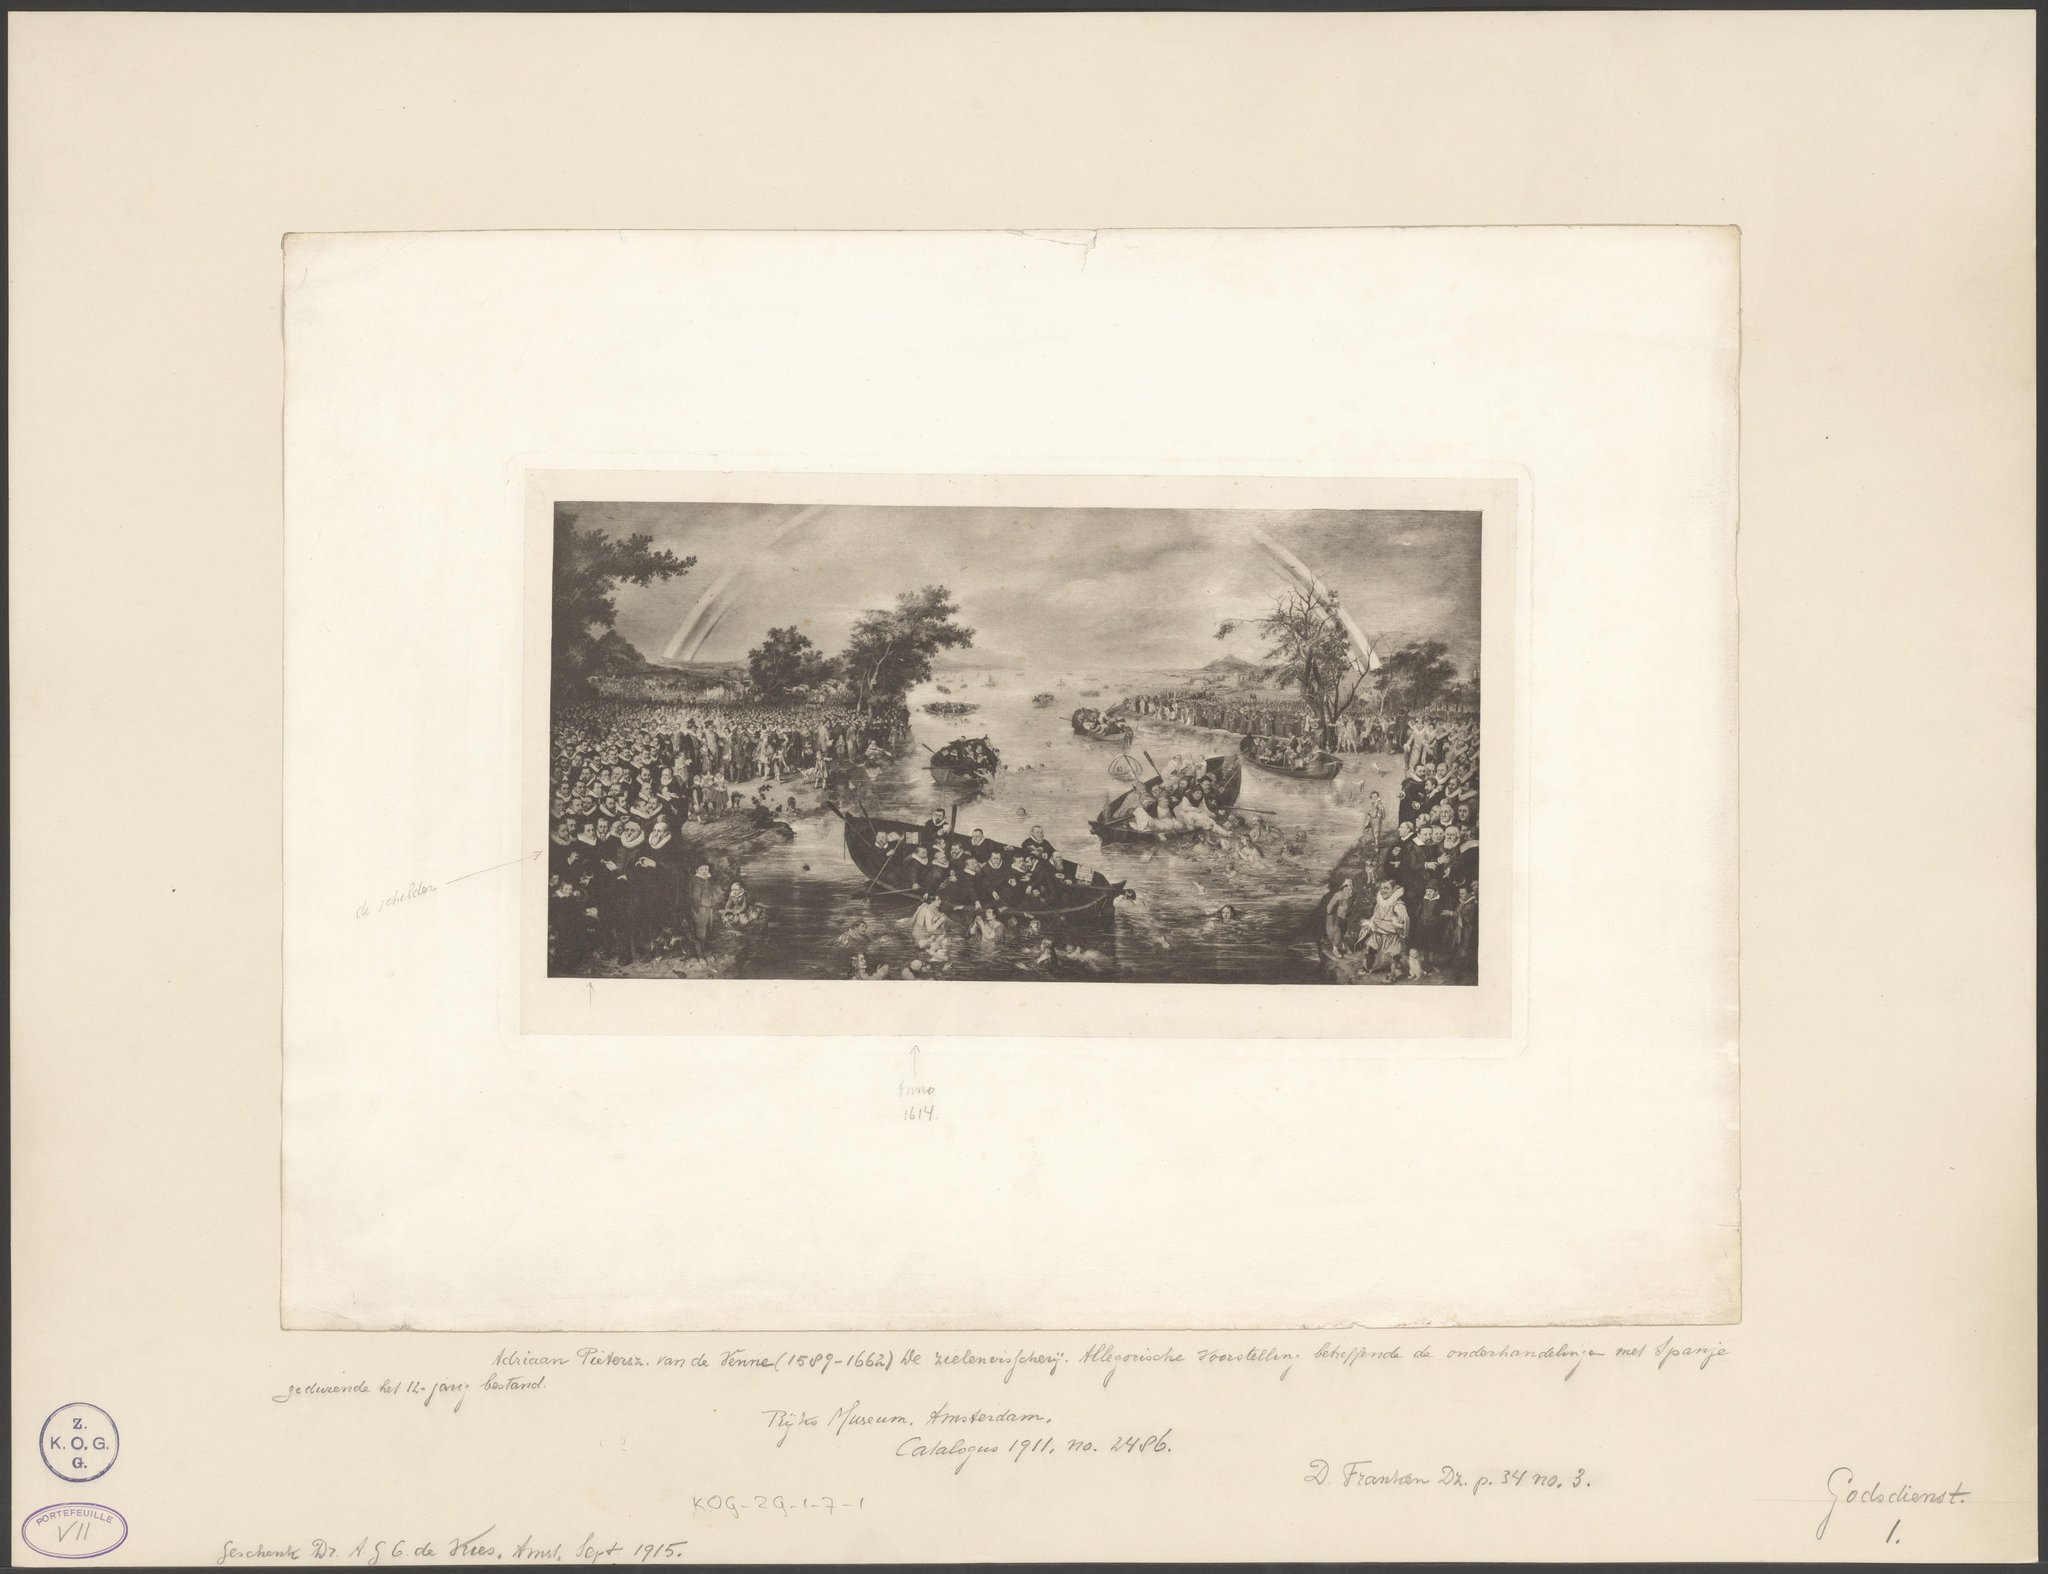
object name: reproduction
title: Reproductie van De zielenvisserij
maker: Anonymous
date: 1875-1930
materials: paper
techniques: blind stamped, photograph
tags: vienna, delft, the hague, print maker, draughtsman, adriaen pietersz van de venne, frederick henry (prince of orange), maurice (prince of orange), frederik v (keurvorst van de palts, koning van bohemen), london, infante van spanje isabella clara eugenia, antwerp, cologne, maria de' medici, jacobus i (koning van engeland), lodewijk xiii (koning van frankrijk), protestant churches and denominations, river, historical persons, rowing-boat, canoe, etc., the (true) church vs. other churches and ideas, rainbow, organization, functionaries and dignitaries in roman catholic church; clergy in general, trying to win souls, fishing for souls, netherlands, spain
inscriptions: stamp, collector's mark: Lugt 1641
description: Onderwerpsrubrieken binnen de Atlas Zeden en Gewoonten: Godsdienst, Ned. Hervormden, (Oudtijds Gereformeerden), Synode van Dordrecht.